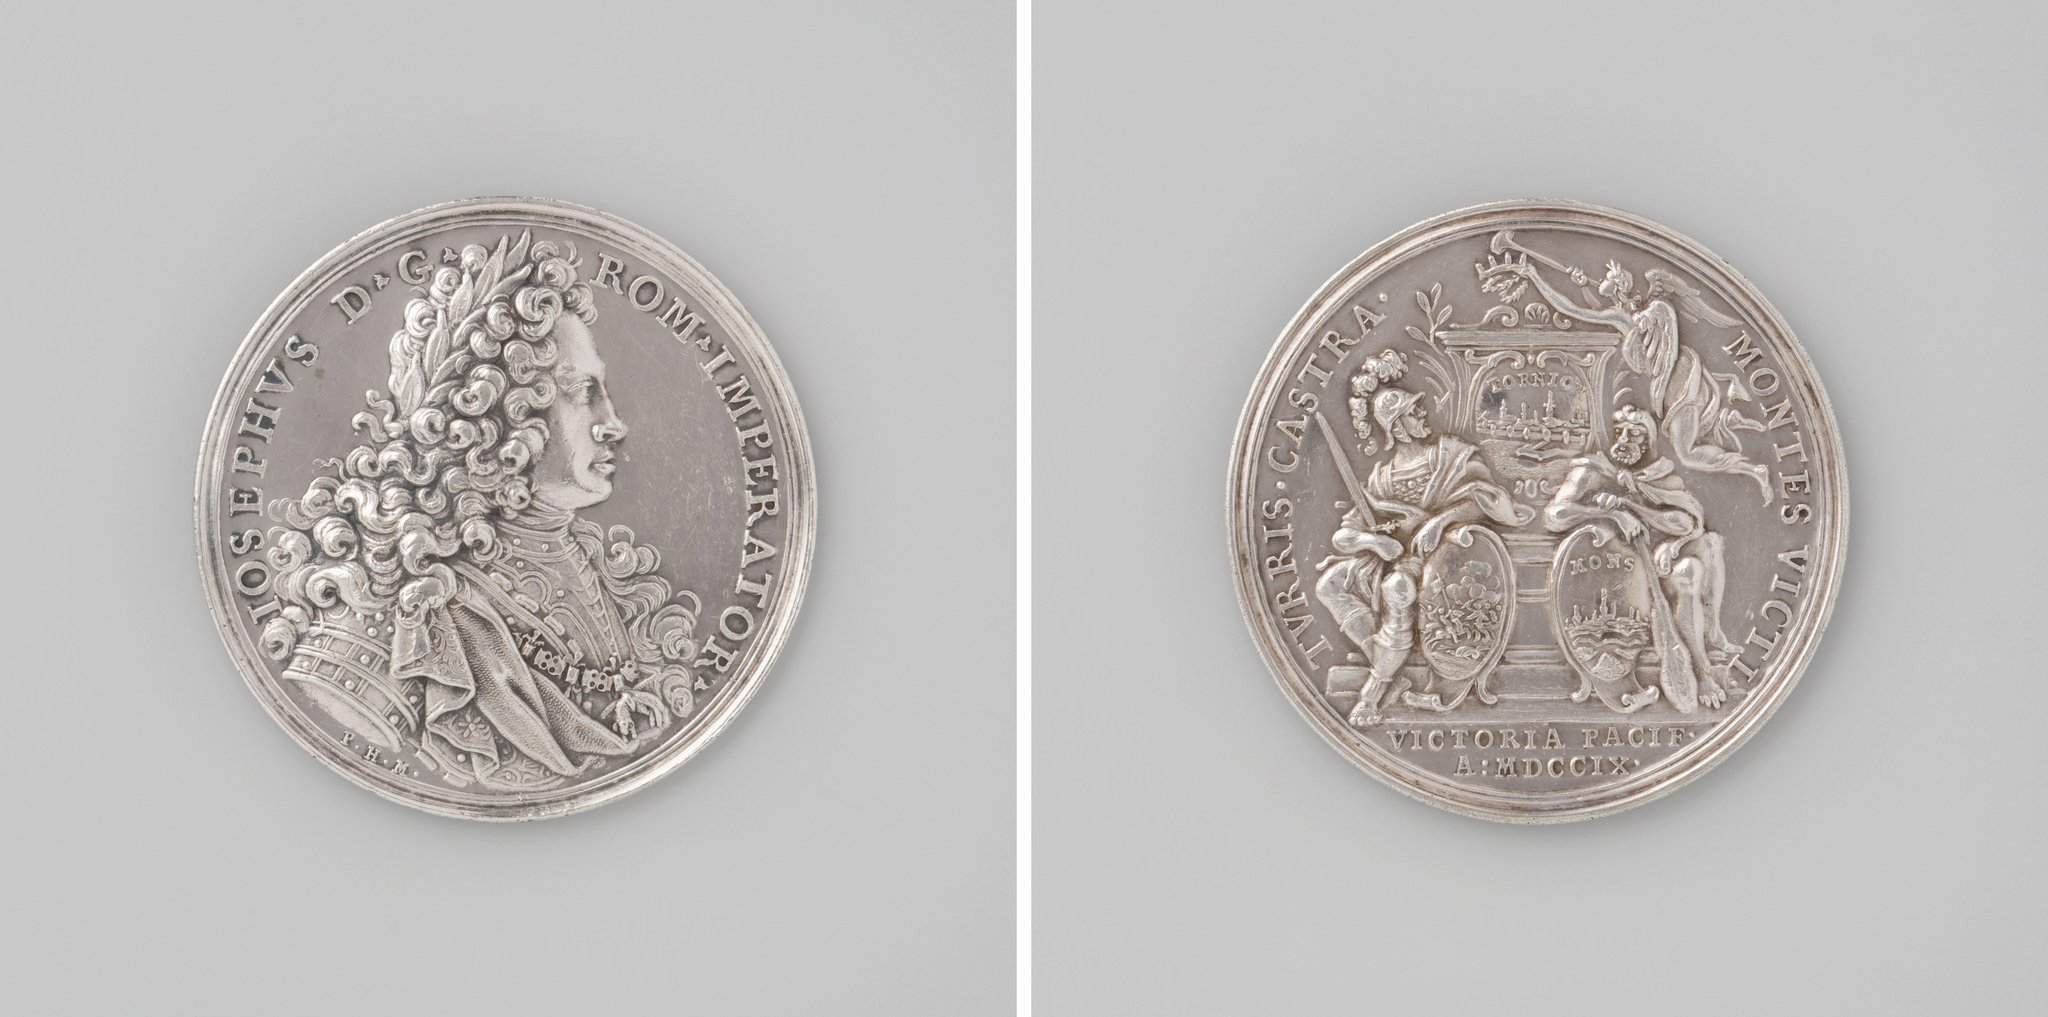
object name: history medal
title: Overwinningen van de bondgenoten in dit jaar behaald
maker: philipp heinrich müller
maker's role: medailleur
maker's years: 1654-1719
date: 1709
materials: silver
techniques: striking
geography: nuremberg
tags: vienna, jozef i (duits keizer), henegouwen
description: Zilveren penning. Voorzijde: borststuk man met lauwerkrans binnen omschrift. Keerzijde: Mars, leunend op schild met afbeelding van slag bij Malplaquet en Herkules met schild met afbeelding van Bergen zittend aan voet van overwinningsmonument met schild met afbeelding van Doornik, waarop Overwinning kroon en twee lauwerkransen legt binnen omschrift, boven opschrift.